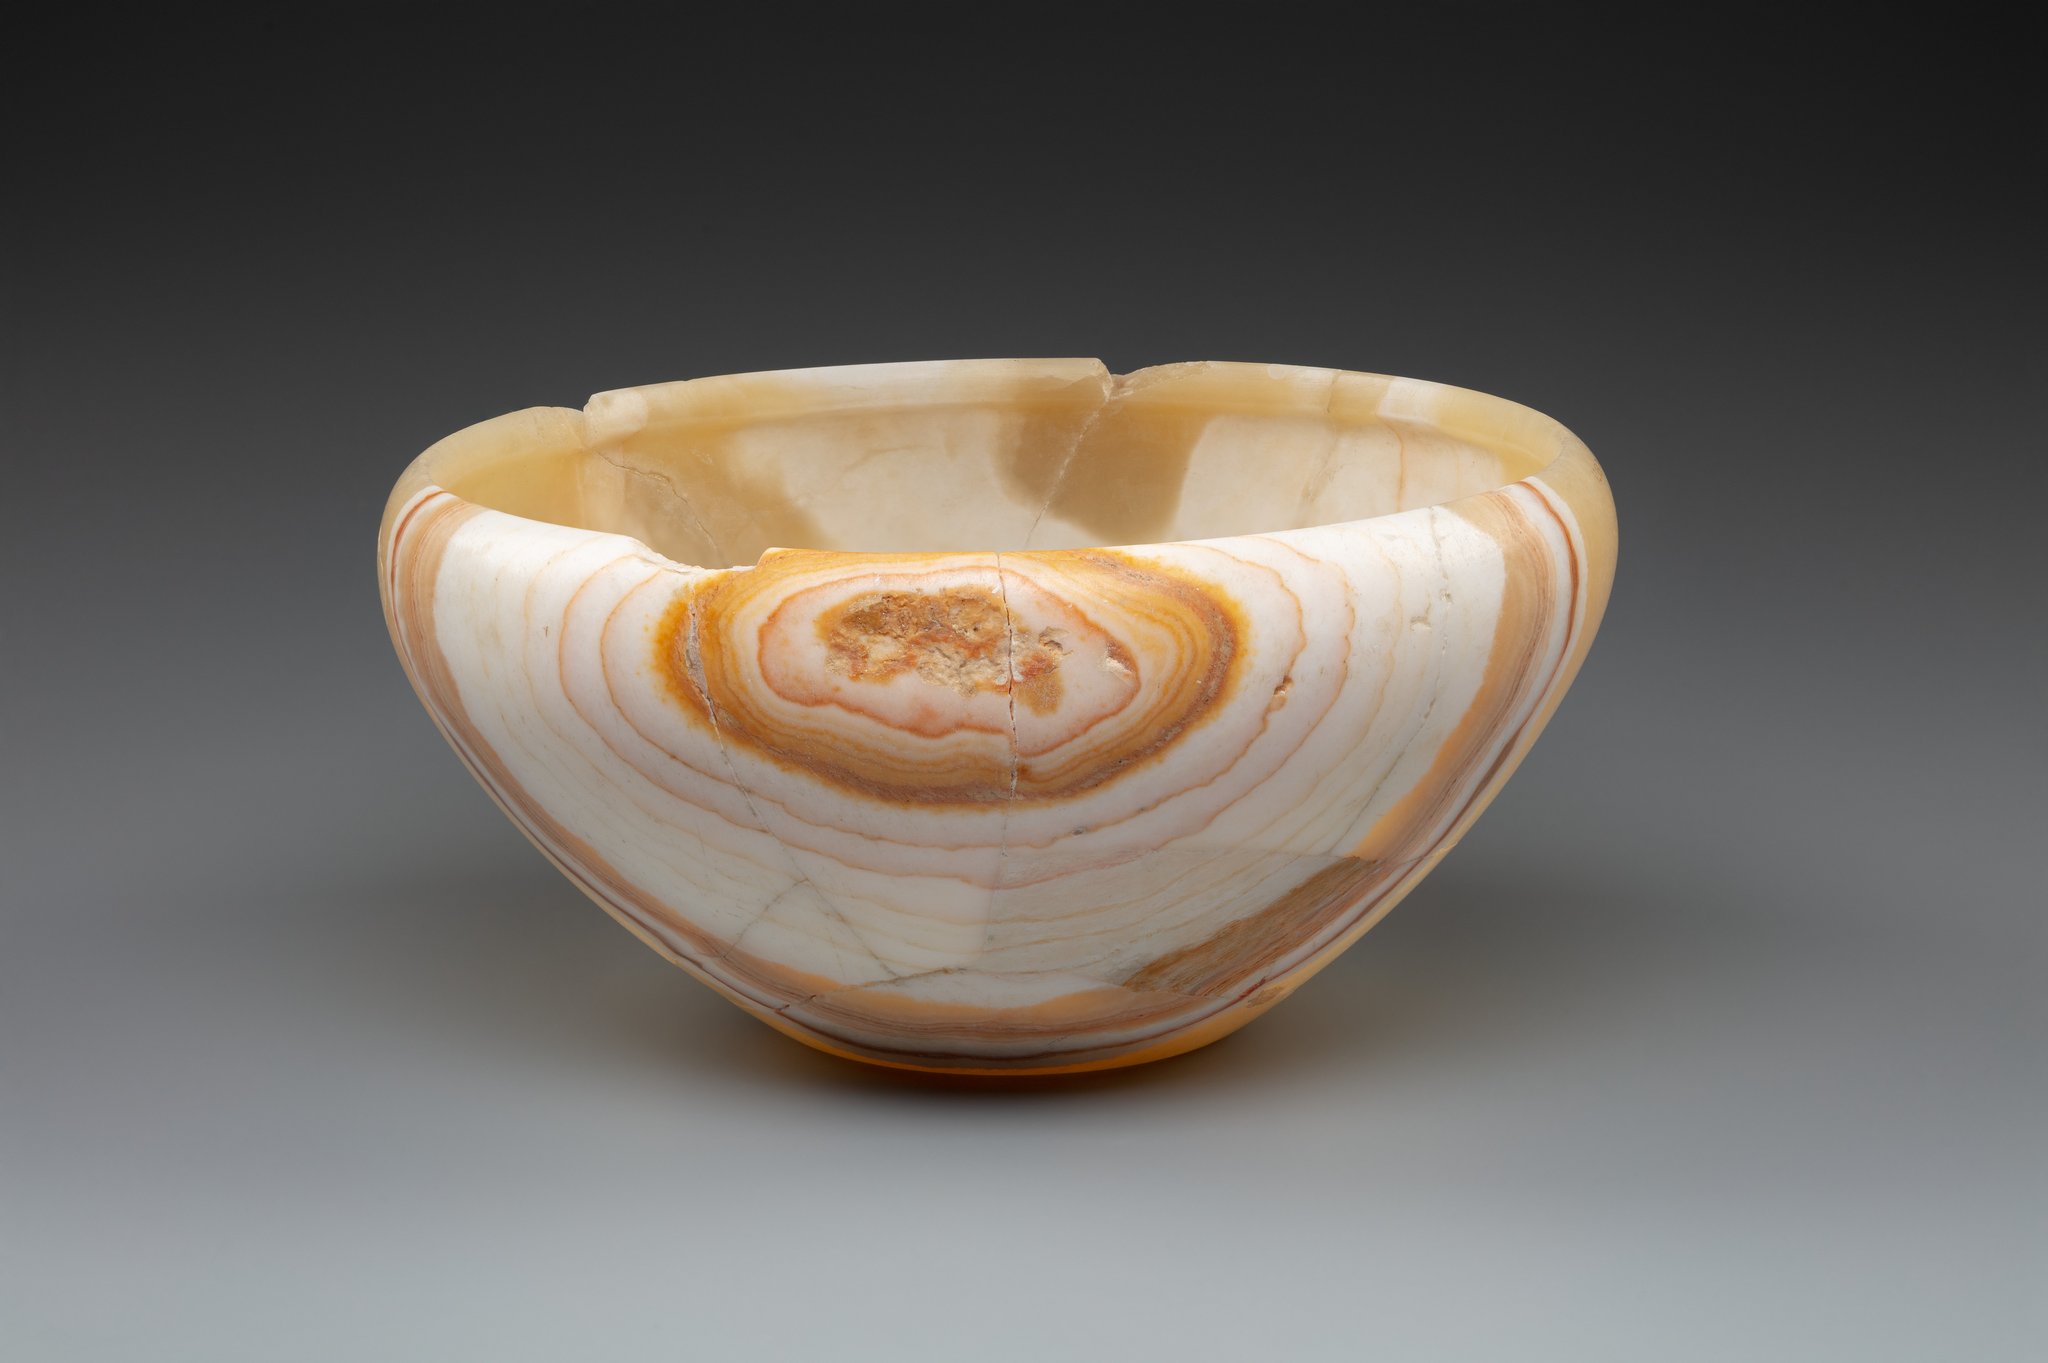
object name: bowl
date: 2750-2649 BCE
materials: stone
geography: egypt